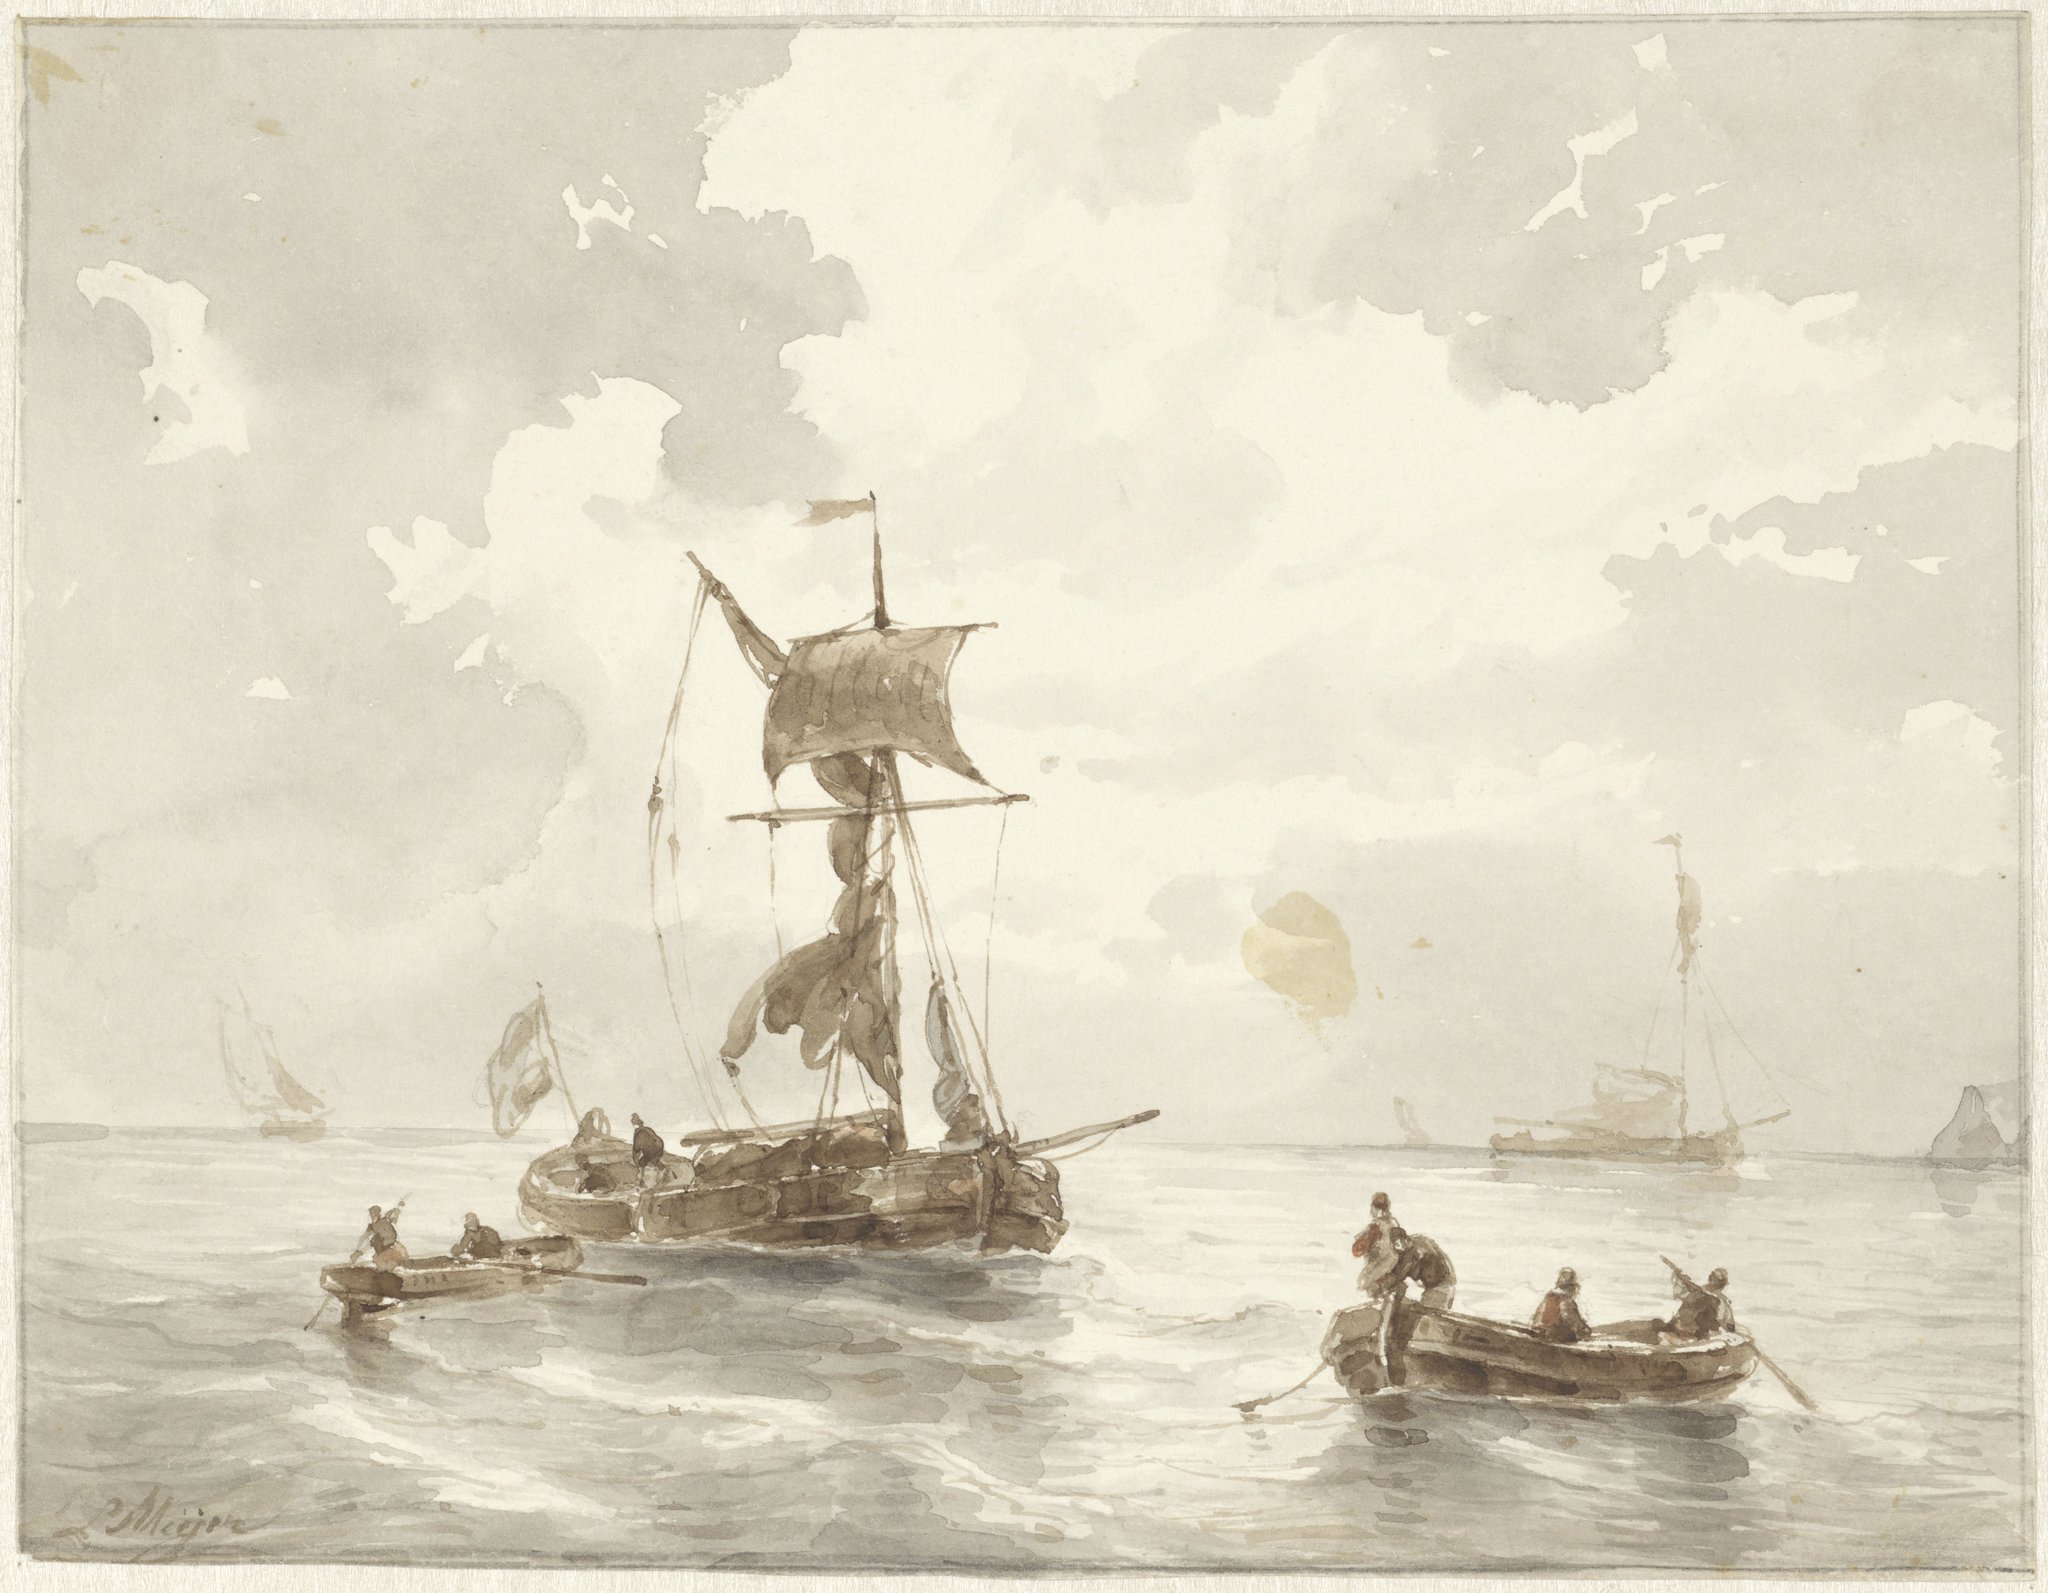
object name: drawing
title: Zeegezicht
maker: louis meijer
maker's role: draughtsman, painter, print maker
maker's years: 1809-1866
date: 1819-1866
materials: paper, pencil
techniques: brush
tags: sailing-ship, sailing-boat, sea (seascape)